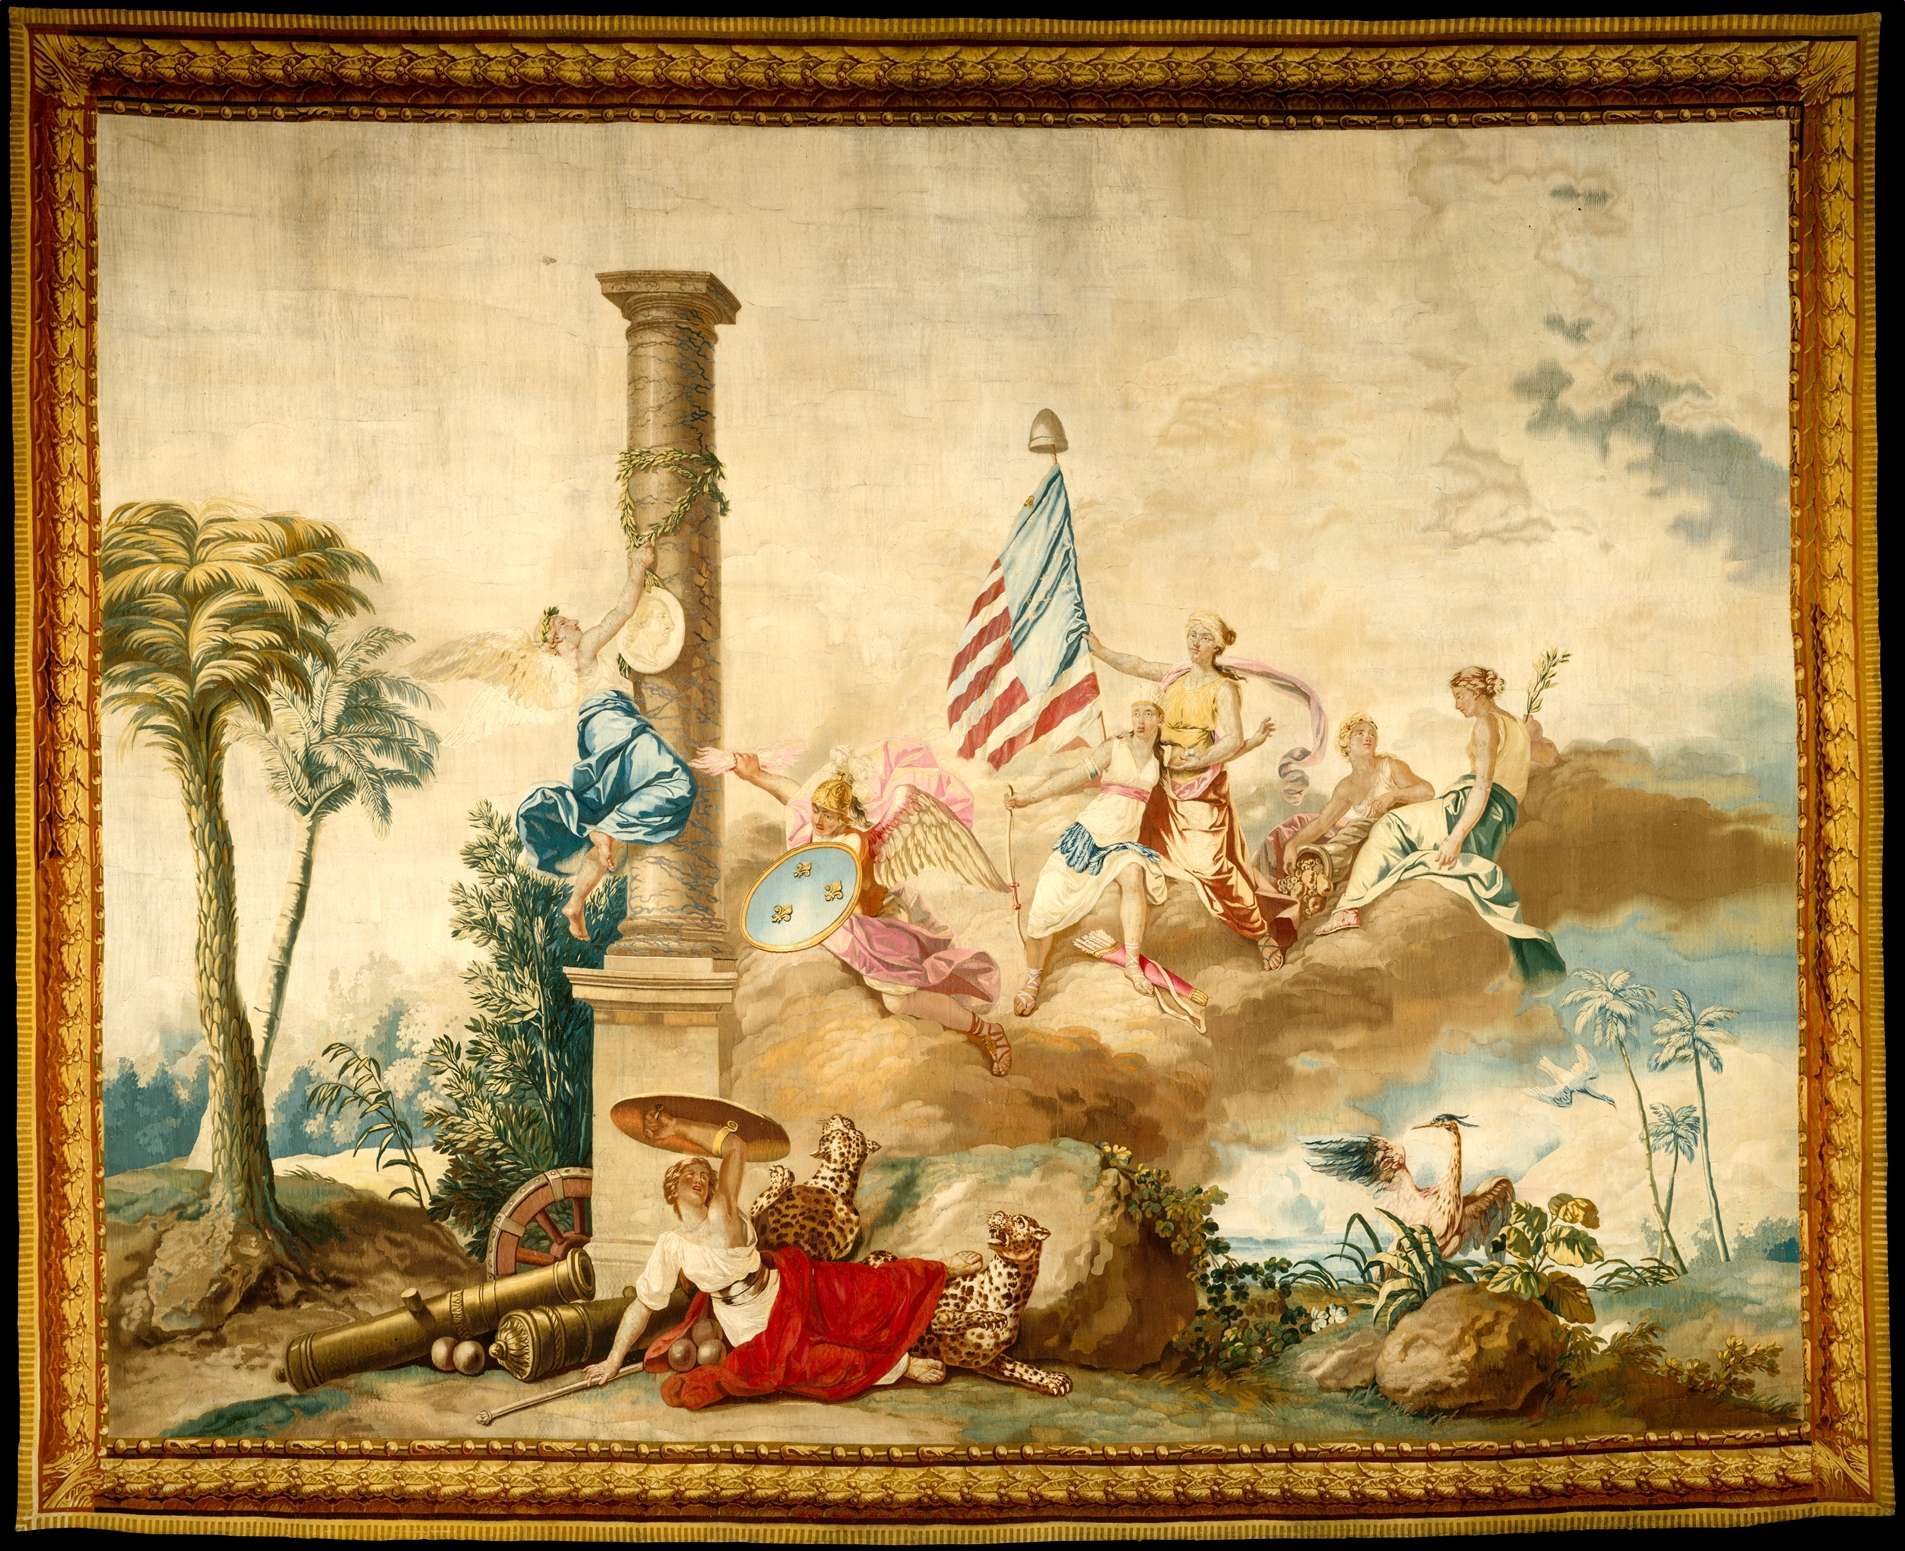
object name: tapestry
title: America from a set of The Four Continents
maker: jean jacques françois le barbier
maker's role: designer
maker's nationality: french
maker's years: 1738-1826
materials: silk, wool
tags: birds,cannons,women,leopards,flags